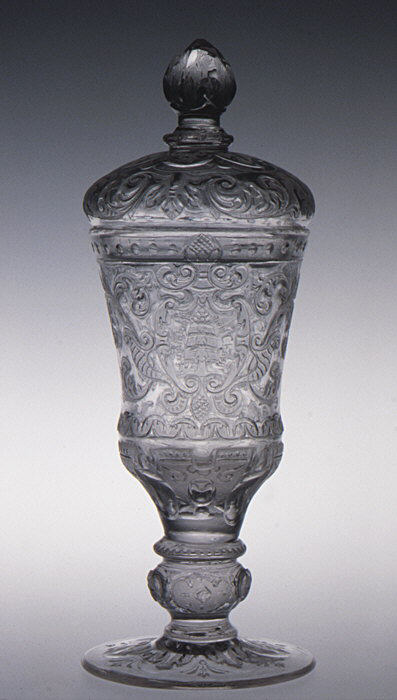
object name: standing cup with cover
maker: friedrich winter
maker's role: maker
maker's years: 1685-1715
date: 1700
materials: glass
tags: coat of arms